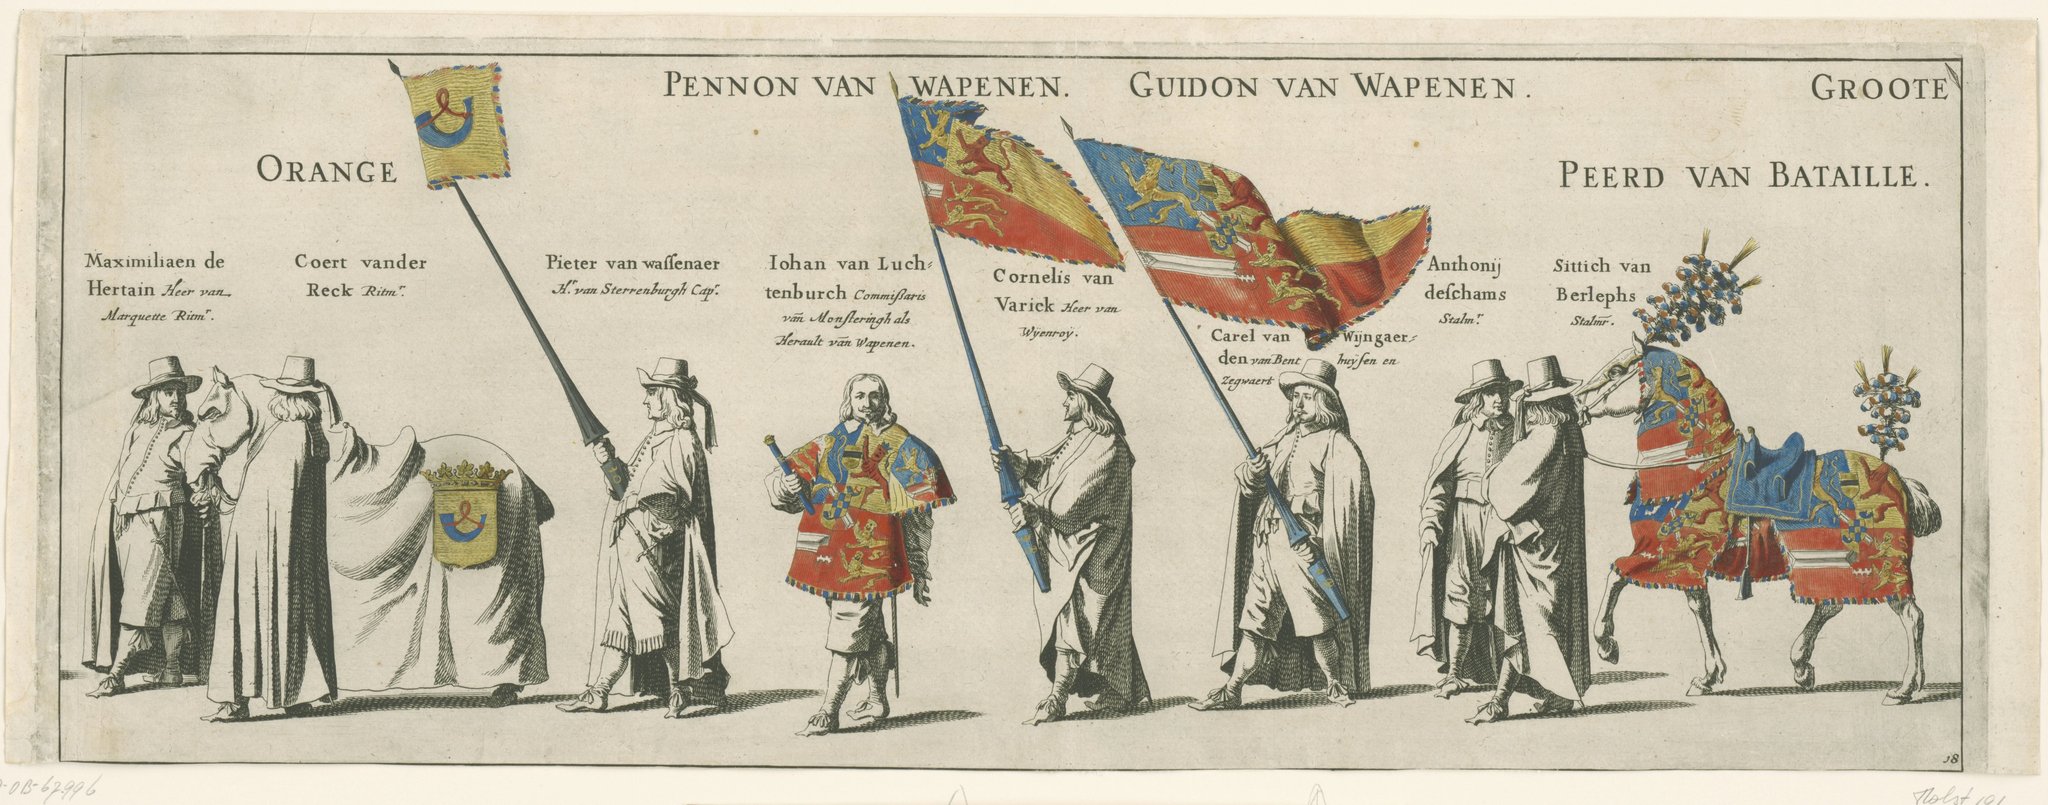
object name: print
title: De begrafenisstoet van stadhouder Frederik Hendrik te 's-Gravenhage in 1647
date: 1647-1651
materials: paper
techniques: etching, hand coloring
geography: amsterdam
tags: the hague, frederick henry (prince of orange), cortege, funeral procession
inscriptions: collector's mark: Lugt 2228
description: De begrafenisstoet van stadhouder Frederik Hendrik te 's-Gravenhage op 10 mei 1647. Plaat nr. 18 met een deel van de stoet met vaandeldragers en twee paarden, boven de personen staan hun naam en functie. Onderdeel van een serie van 30 platen en 20 tekstbladen, bedoeld om aan elkaar geplakt te worden.